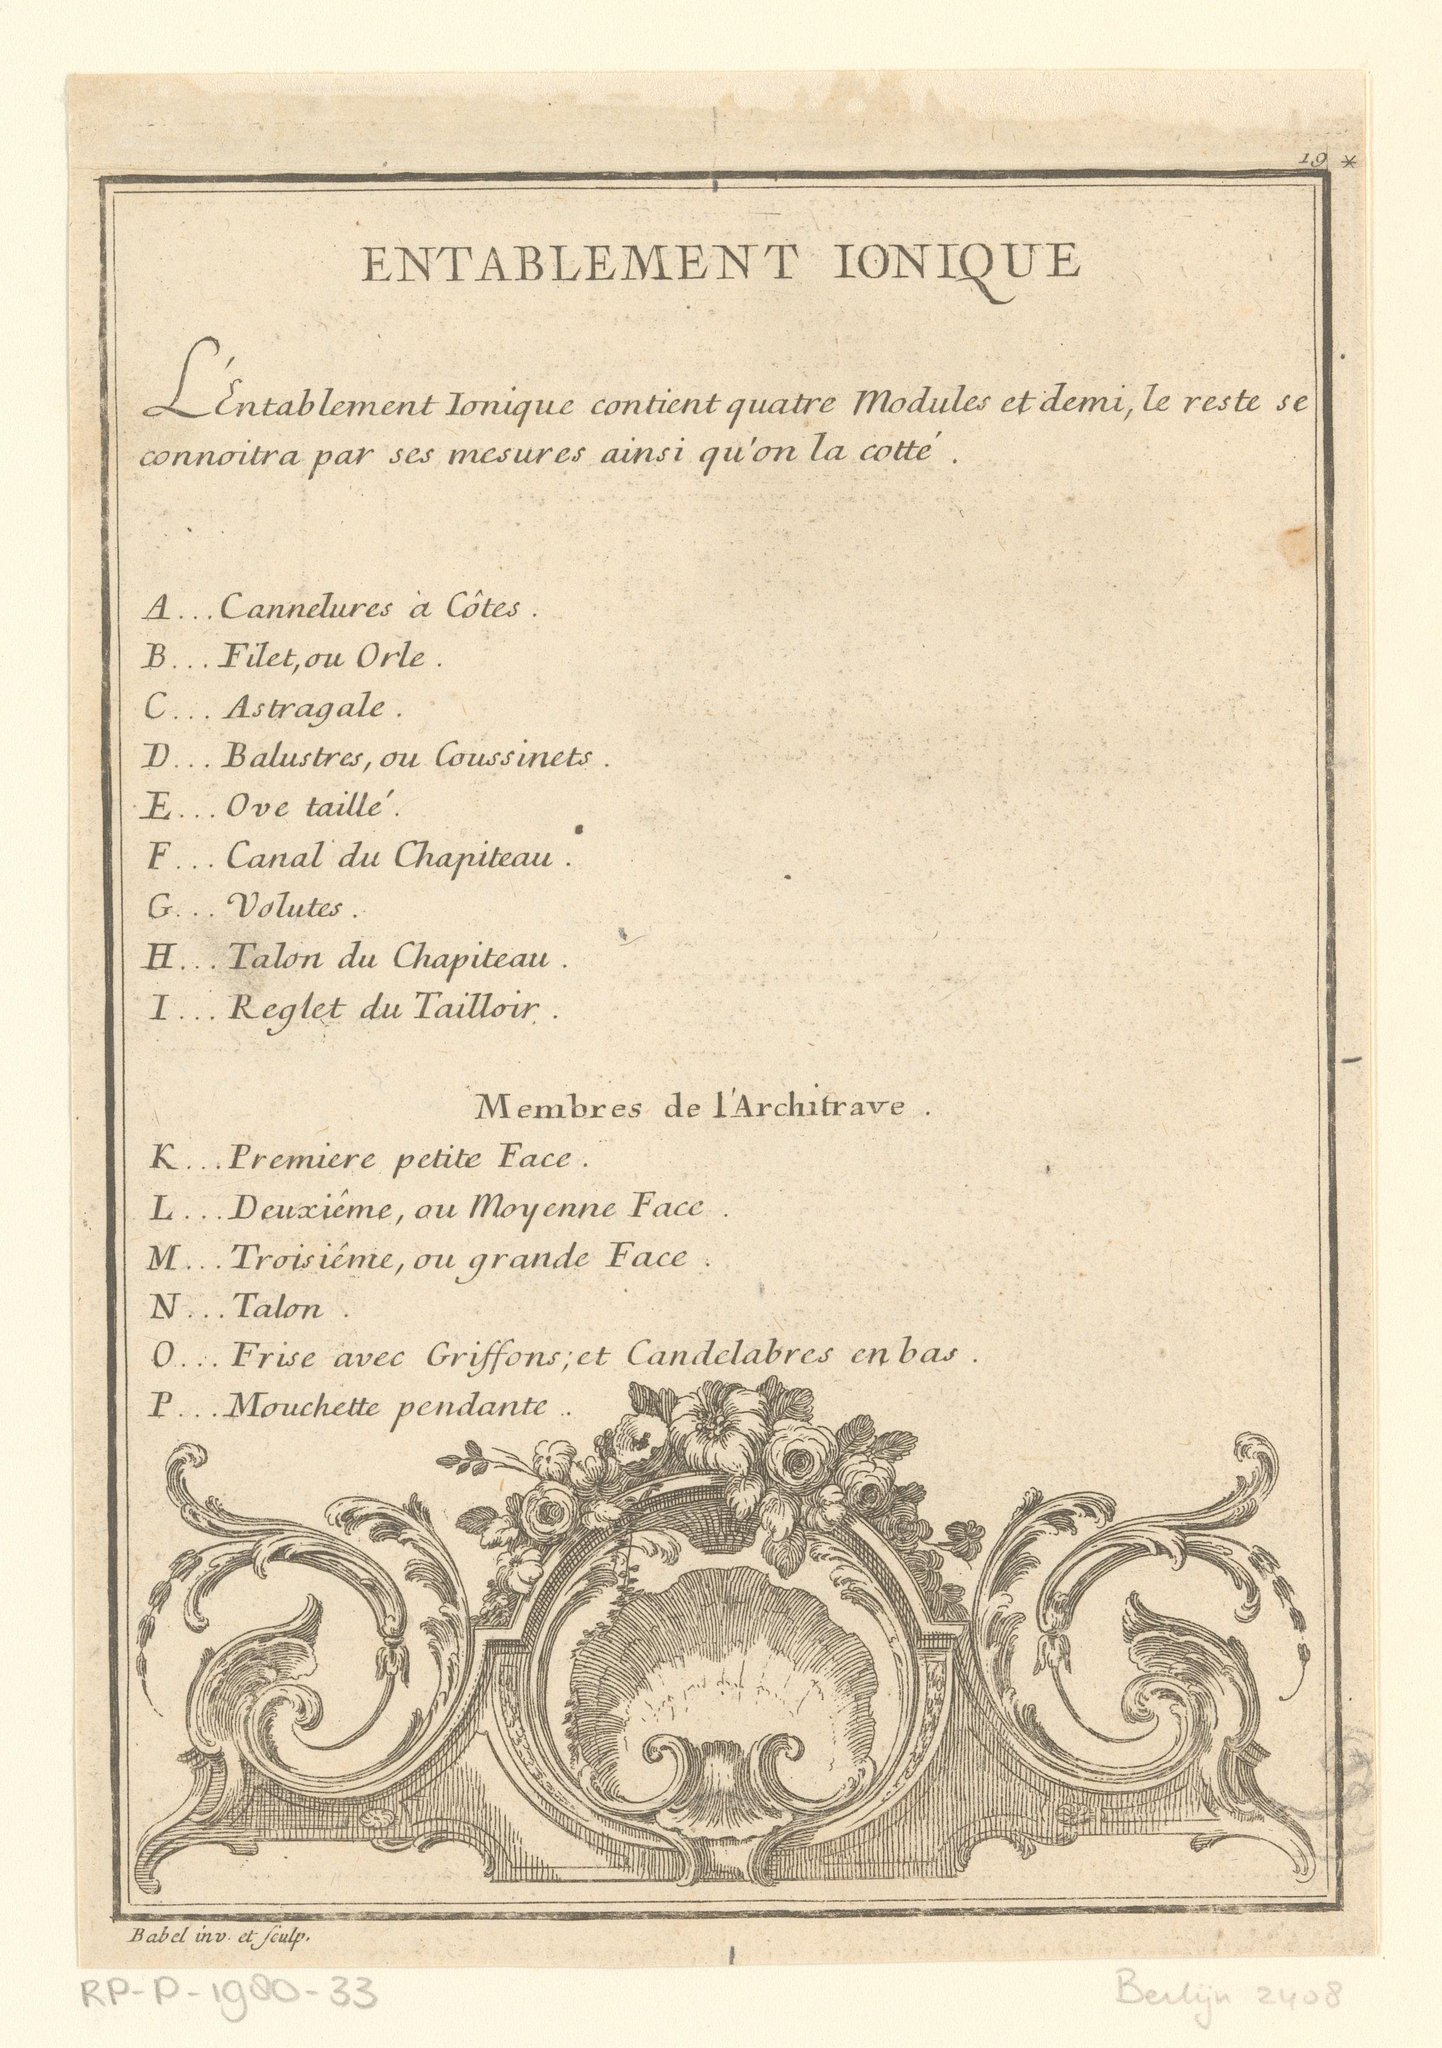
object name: book illustration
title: Le Nouveau Vignole ou Regles Des Cinq Ordres D'Architecture (...)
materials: paper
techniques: etching, letterpress printing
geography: paris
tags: rocaille ornament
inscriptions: collector's mark: Lugt 2228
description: Pagina 19 uit: Babel, Pierre Edme. Le Nouveau Vignole ou Regles Des Cinq Ordres D'Architecture (...). Parijs: Chereau, François (II), 1755.